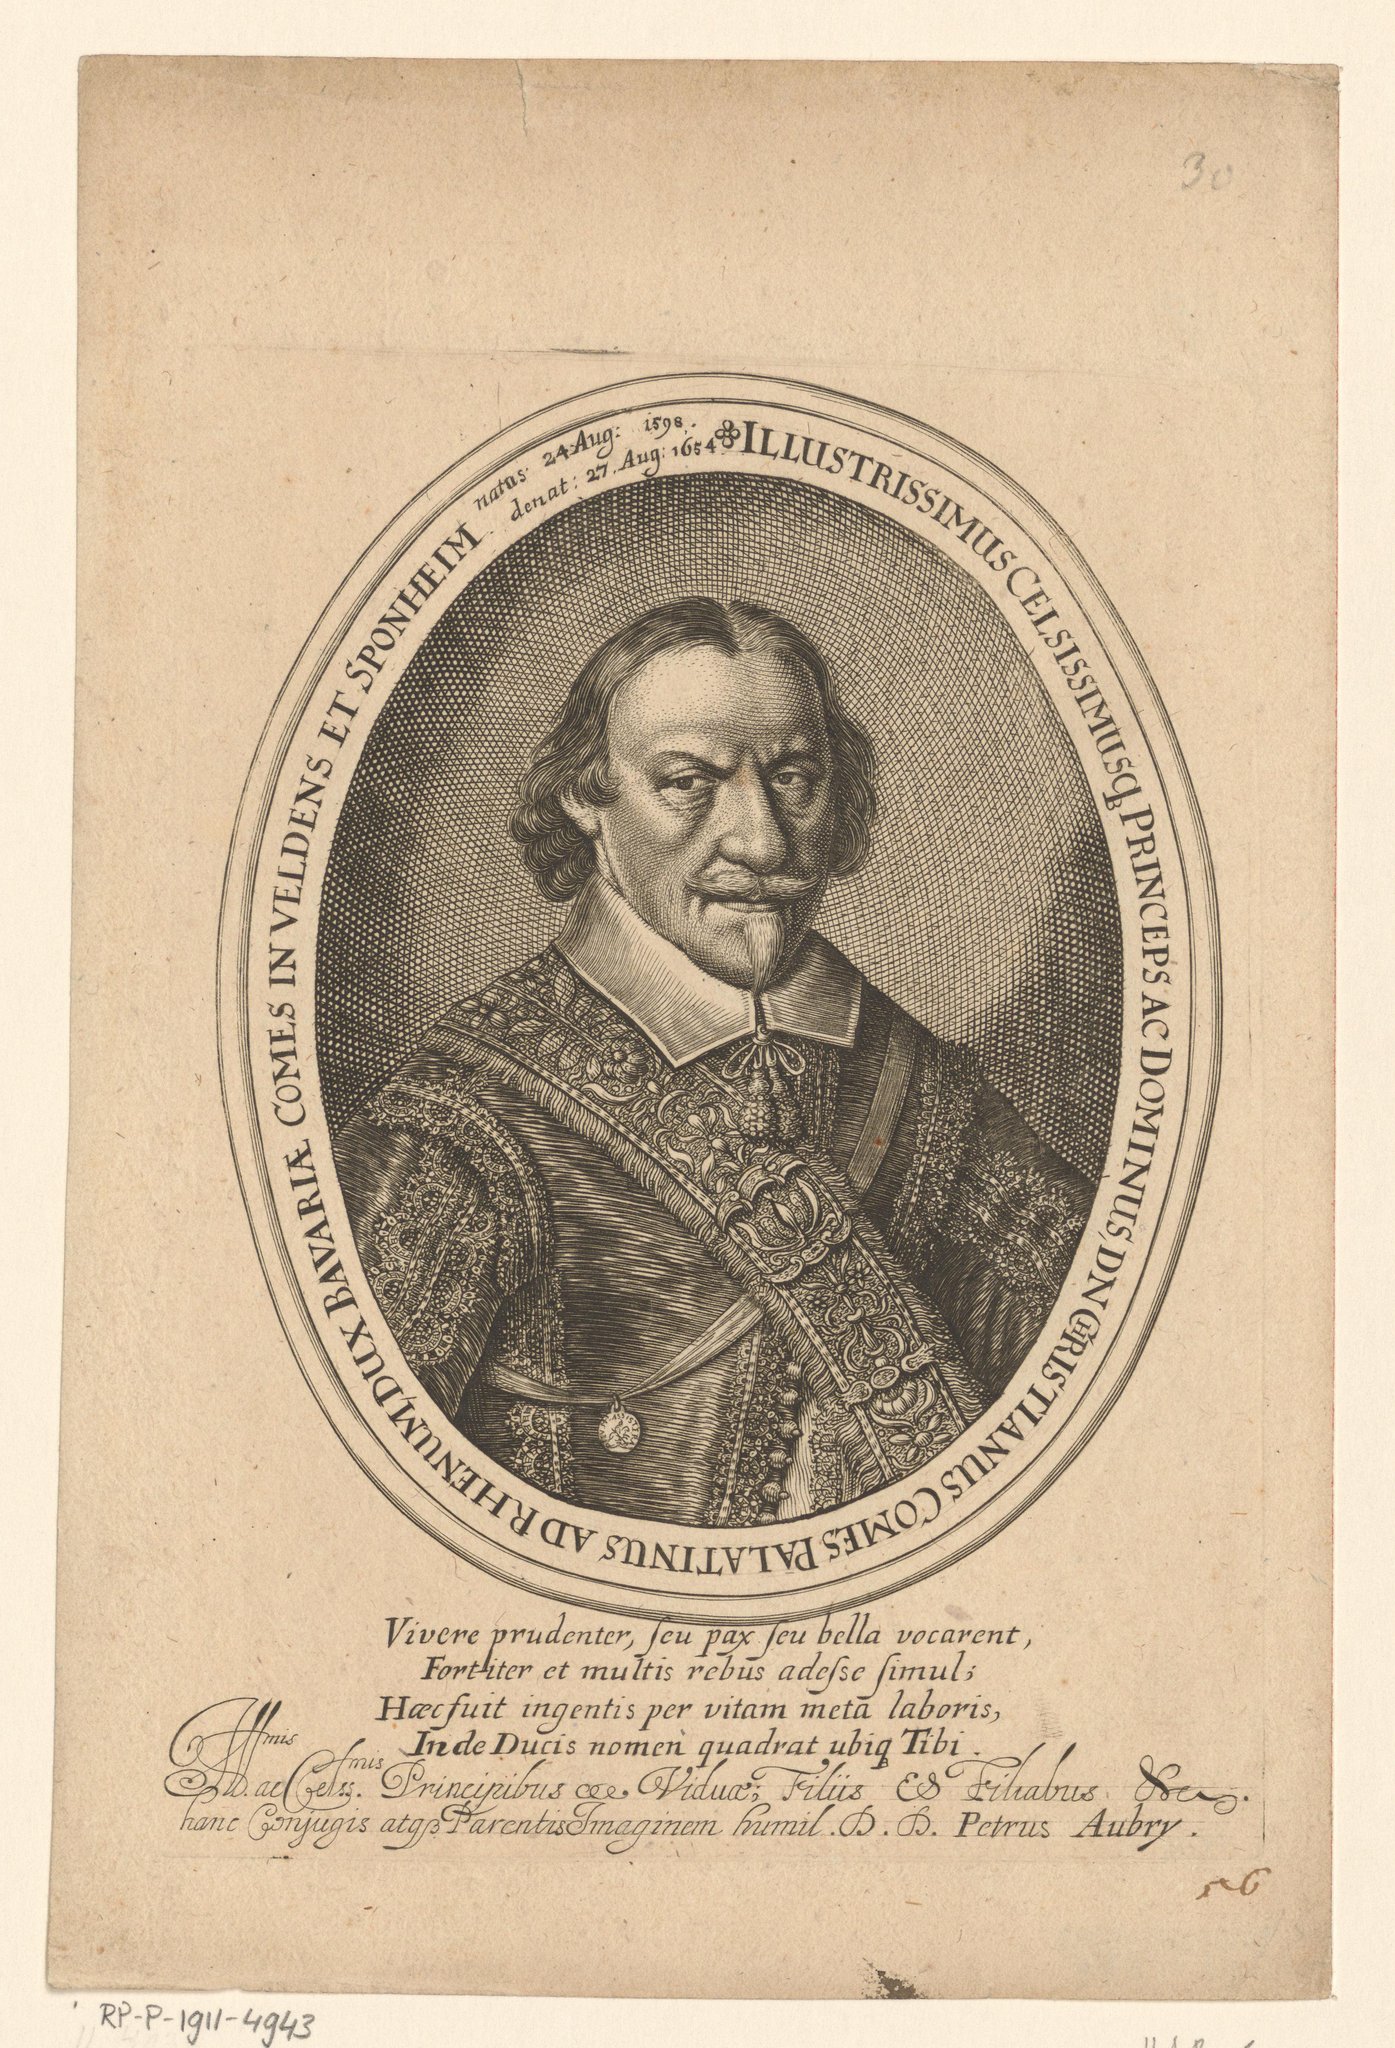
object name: print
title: Portret van Christiaan I van Palts-Birkenfeld-Bischweiler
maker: peter aubry (ii)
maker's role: print maker, publisher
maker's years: 1596-1668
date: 1654-1666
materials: paper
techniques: engraving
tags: historical persons, king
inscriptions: collector's mark: Lugt 2282